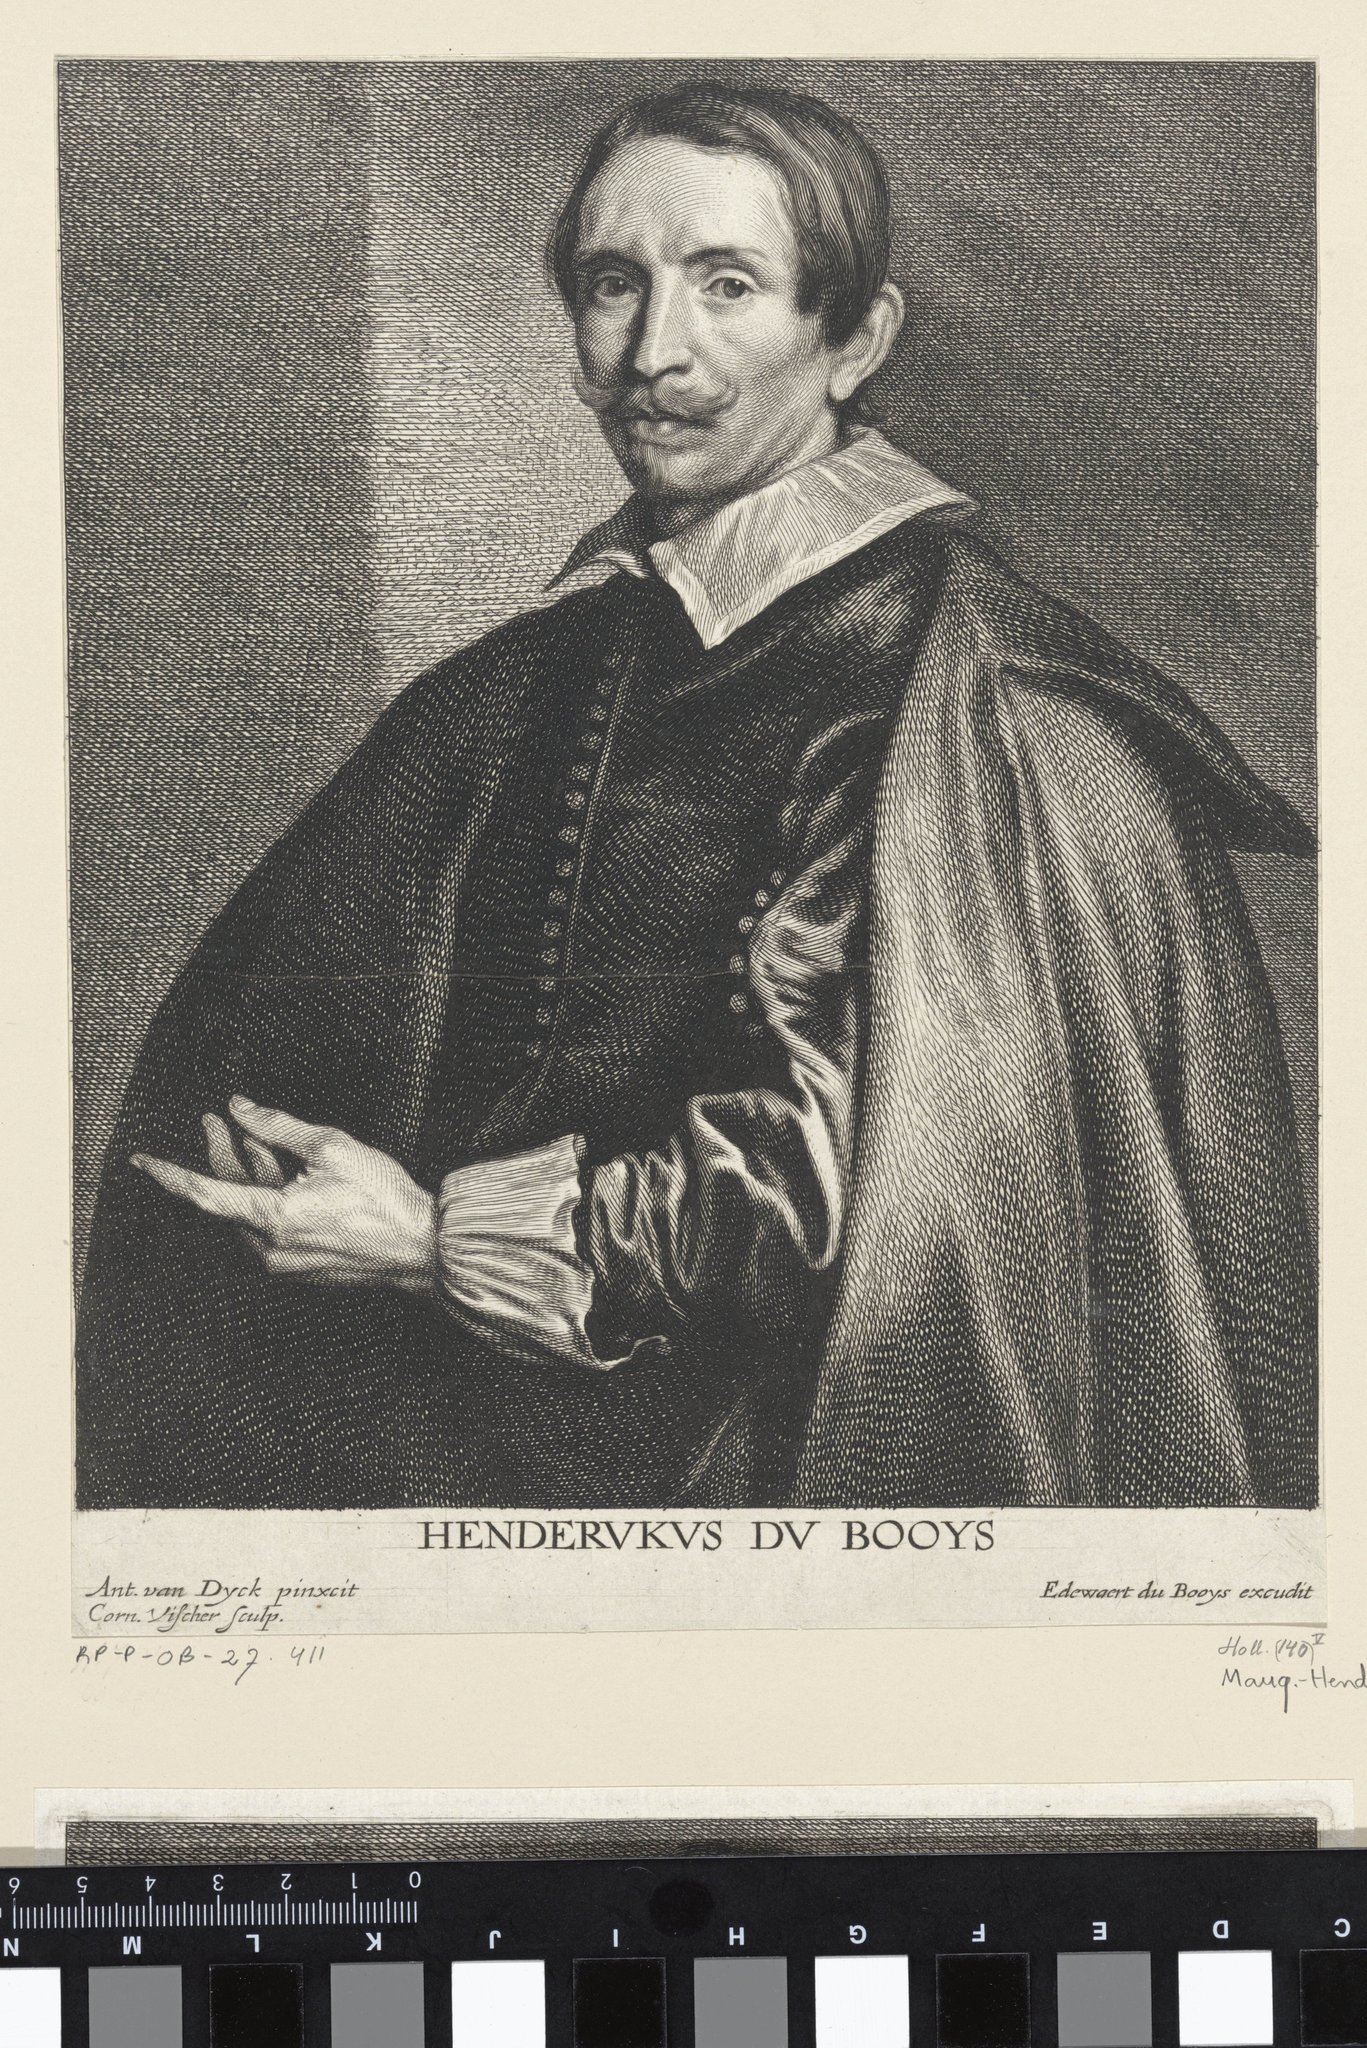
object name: print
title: Portret van de schilder Hendrick Dubois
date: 1638-1696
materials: paper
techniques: engraving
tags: antwerp, rotterdam, painter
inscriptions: collector's mark: Lugt 240